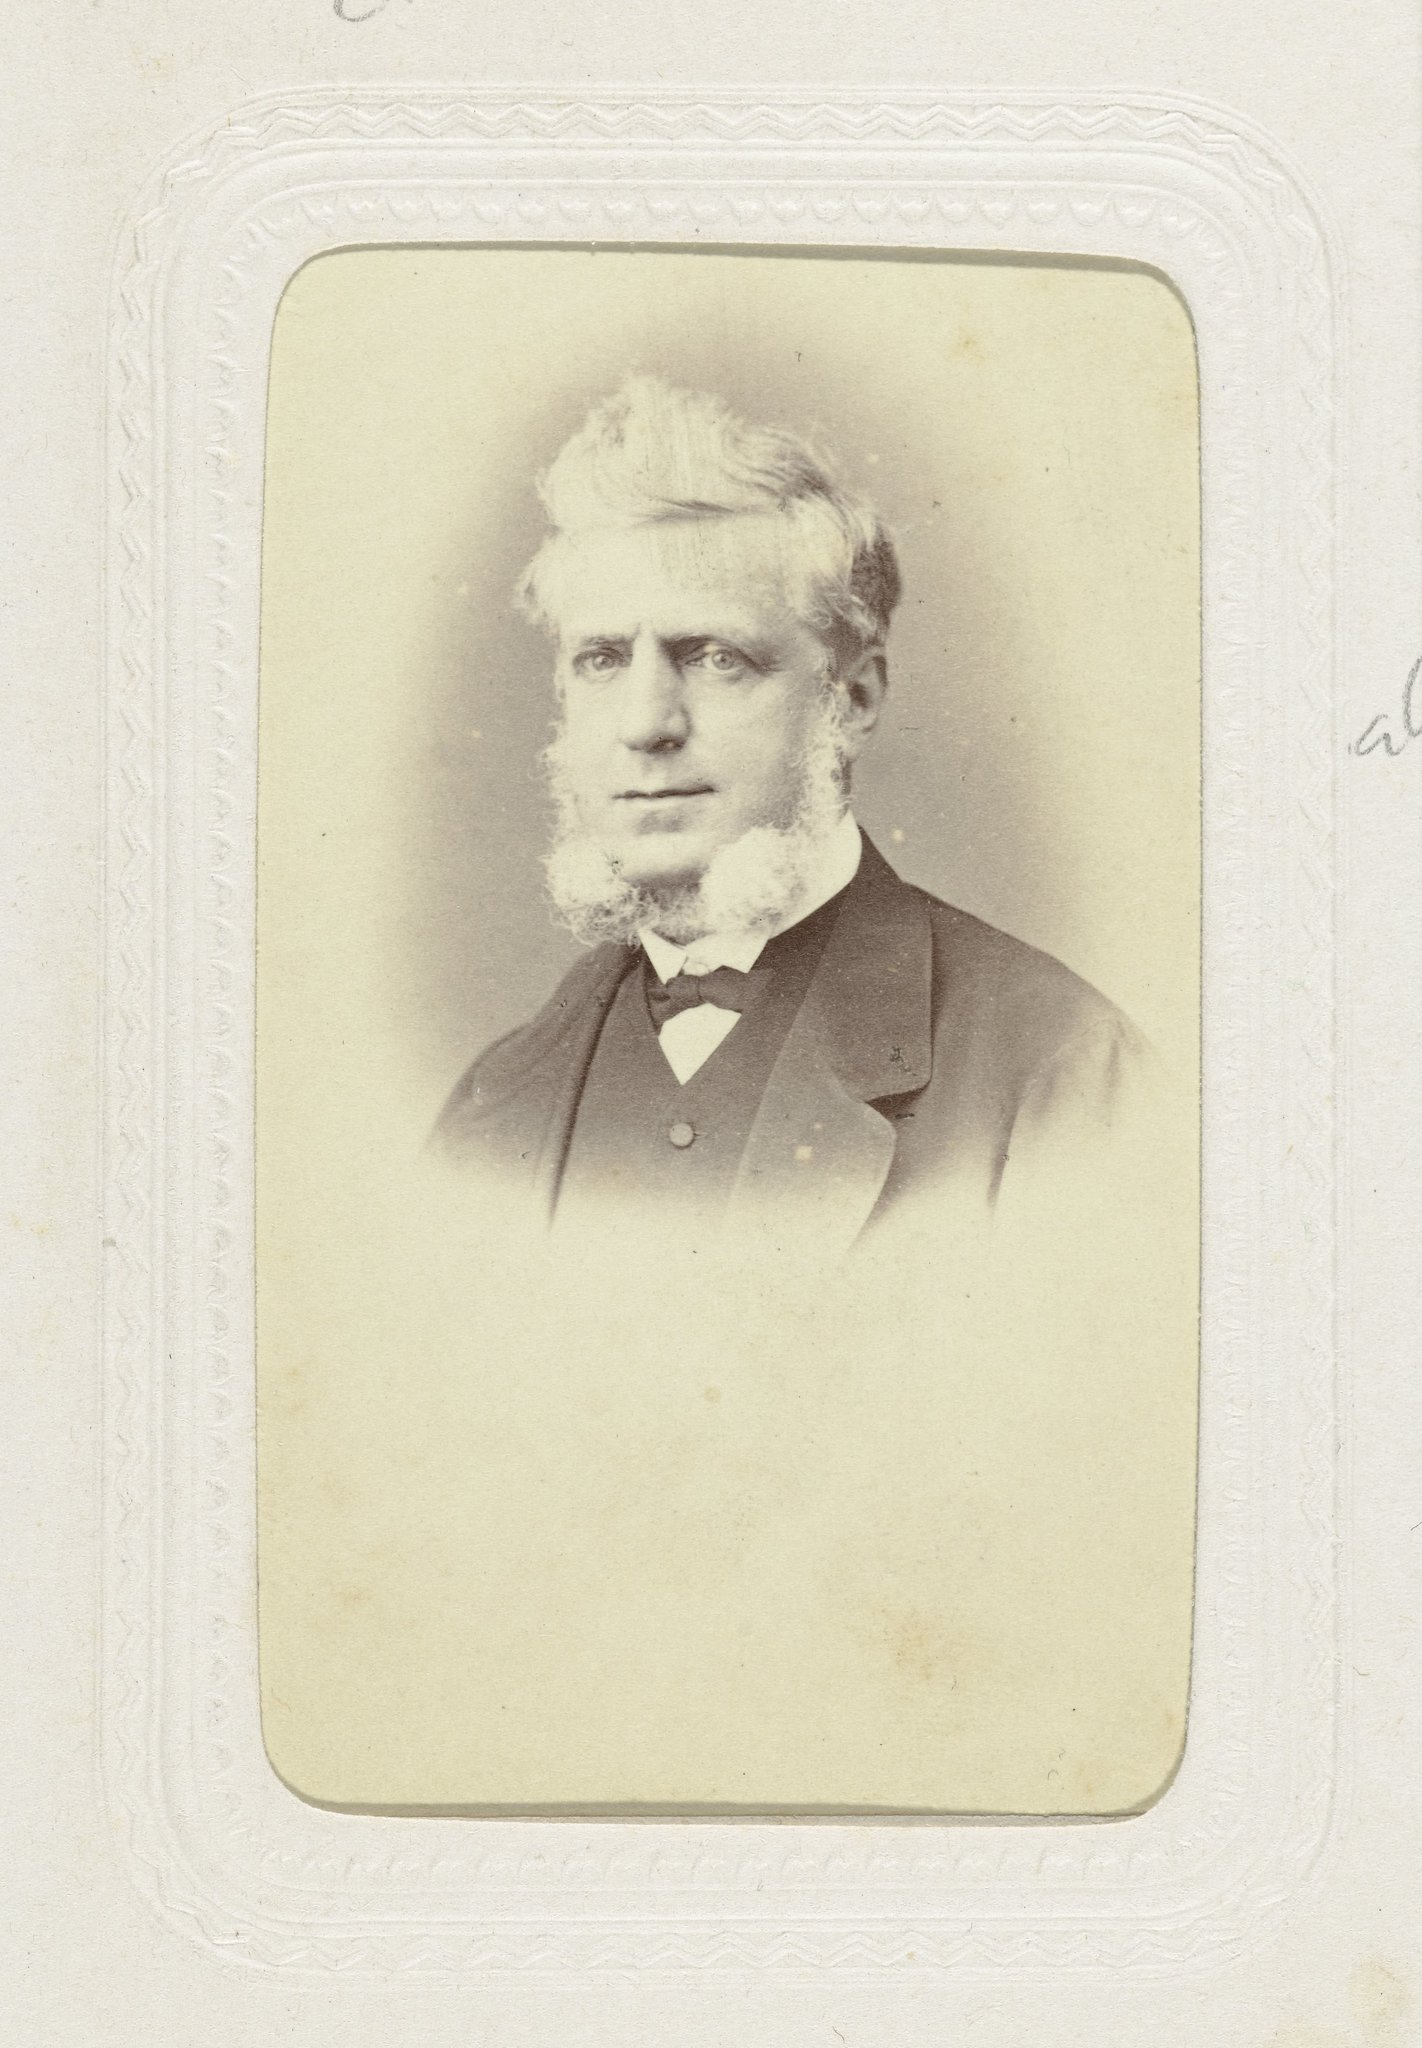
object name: carte de visite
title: Portret van Prof. Dr. Jan van Geuns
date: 1863-1866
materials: cardboard, paper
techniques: albumen print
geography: istanbul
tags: amsterdam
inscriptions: inscription: ‘To profesor Von Geuns. A souvenir of the conference 1866. Edw. Goodew.’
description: Zie ook: Stadsarchief Gemeente Amsterdam [http://beeldbank.amsterdam.nl/beeldbank/weergave/record/?id=010097008465] en het Album Academicum van de Universiteit van Amsterdam [http://albumacademicum.uva.nl/].